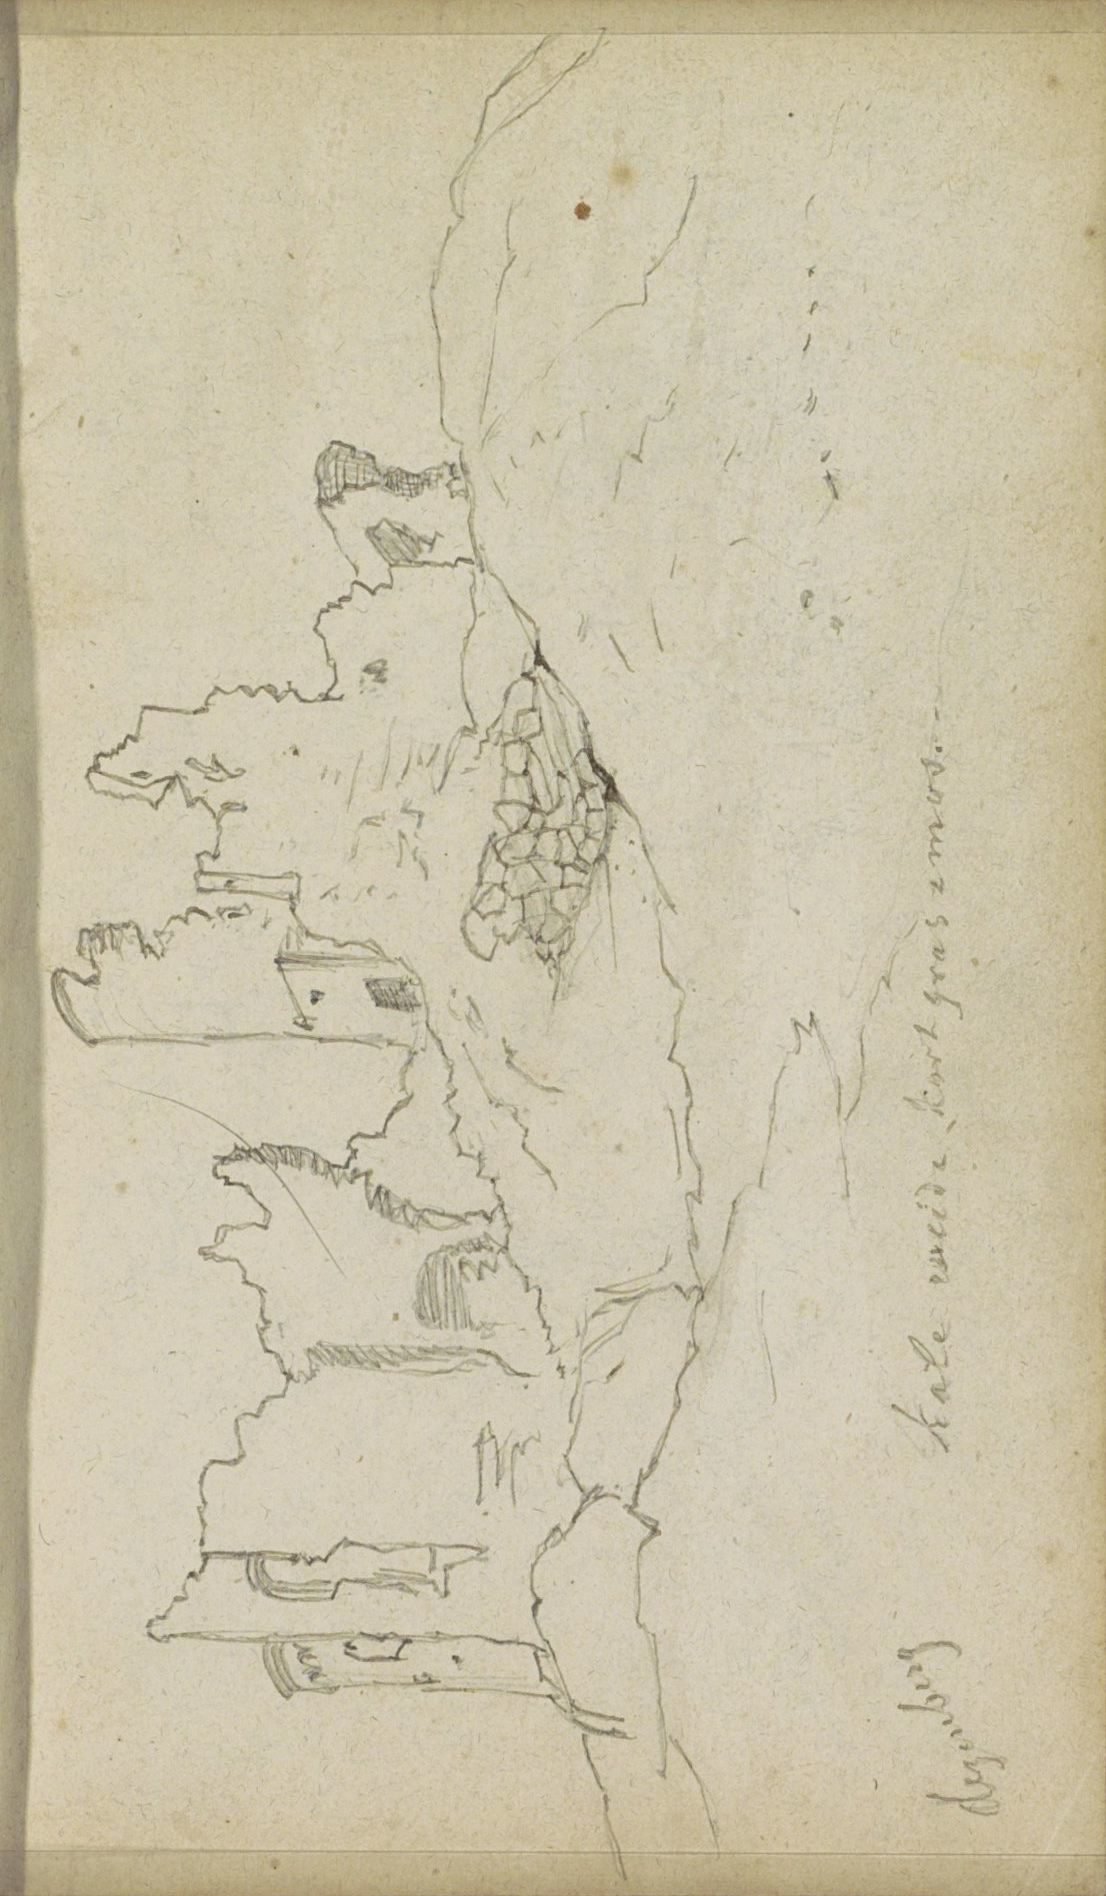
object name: sketchbook leaf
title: Kasteelruïne op de Desenberg bij Warburg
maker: johannes tavenraat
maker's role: draughtsman, painter, print maker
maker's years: 1809-1881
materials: ink, paper, pencil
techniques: pen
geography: warburg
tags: ruin of a dwelling, house, castle, etc.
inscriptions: annotation: ‘dezenberg’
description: Blad 6 recto uit een schetsboek met 88 bladen.